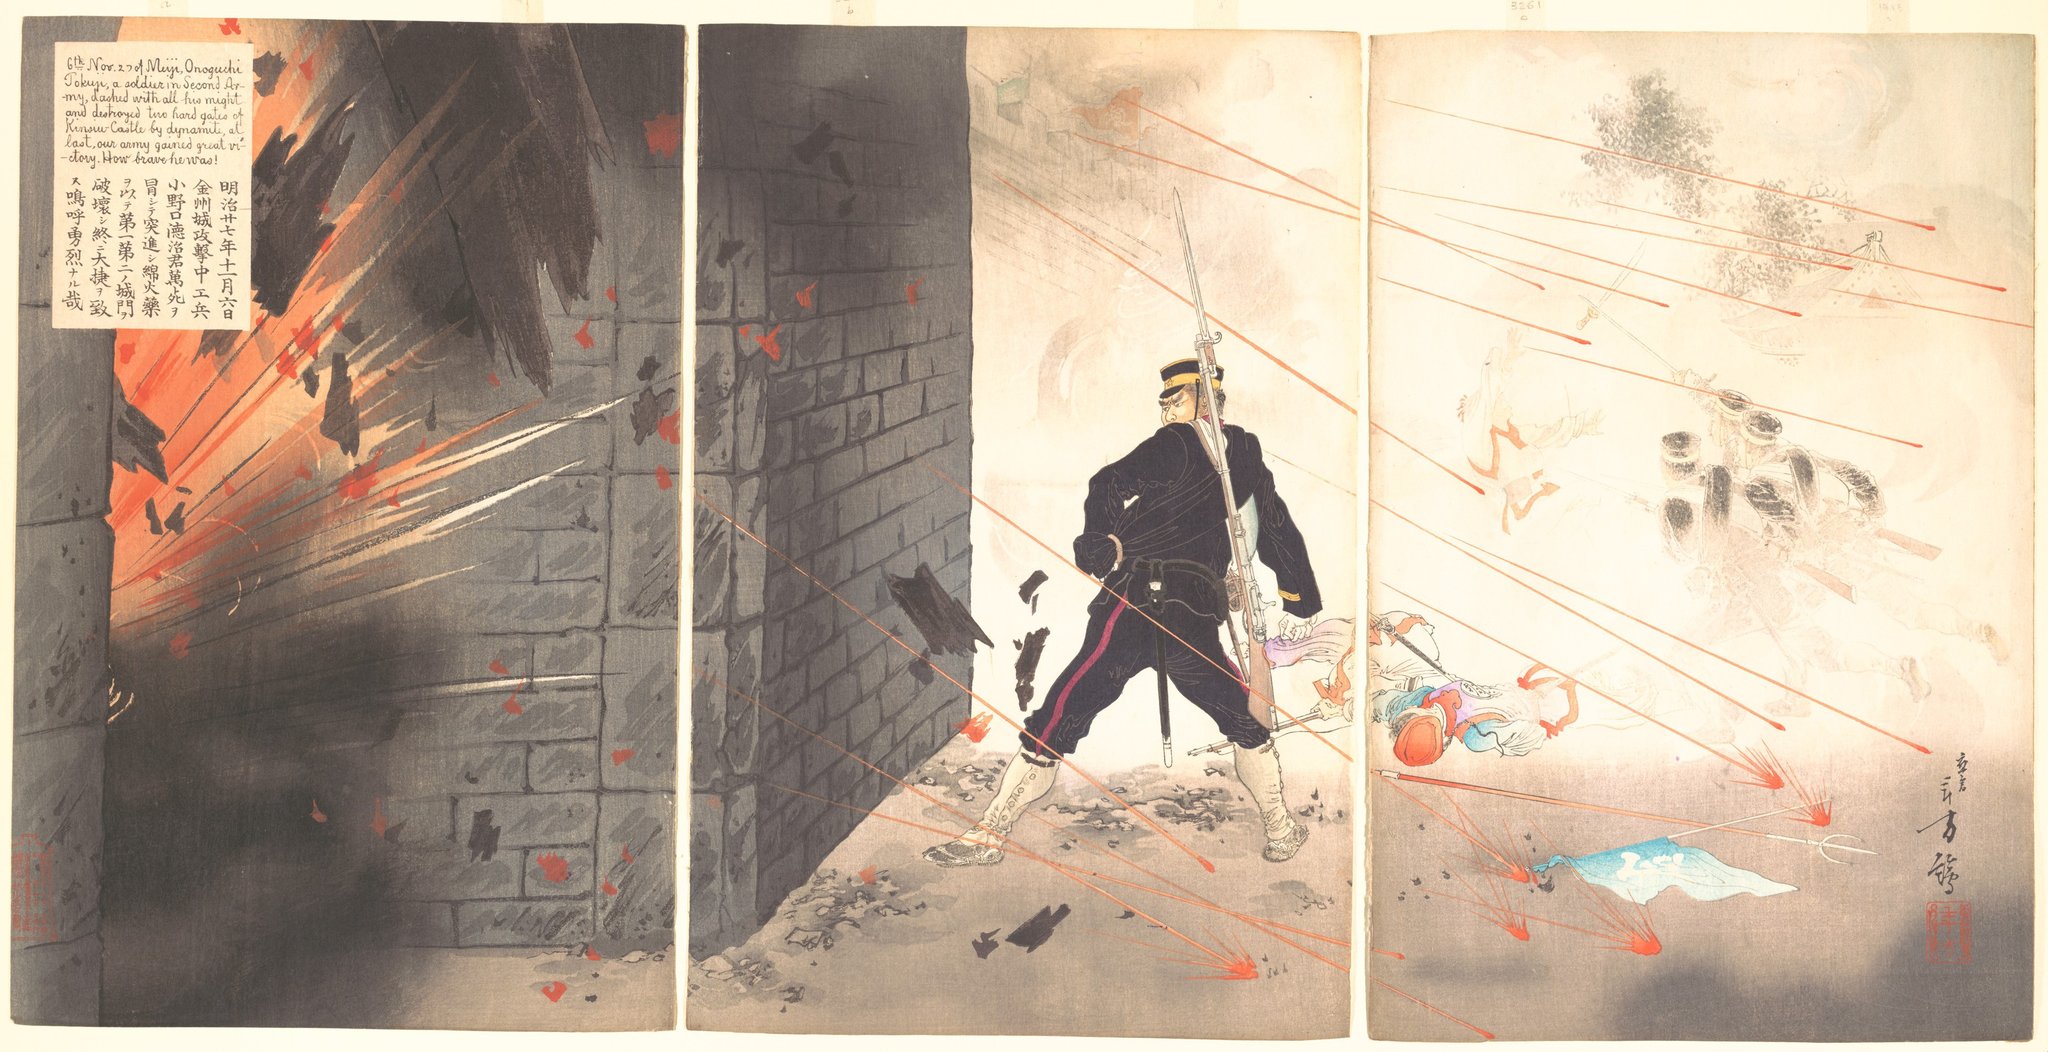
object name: print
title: Onoguchi Tokuji during the Siege of Jinzhou Fortress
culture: japanese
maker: mizuno toshikata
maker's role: artist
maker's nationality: japanese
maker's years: 1866-1908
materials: ink, paper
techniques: nishiki e, woodblock print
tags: castles,firearms,men